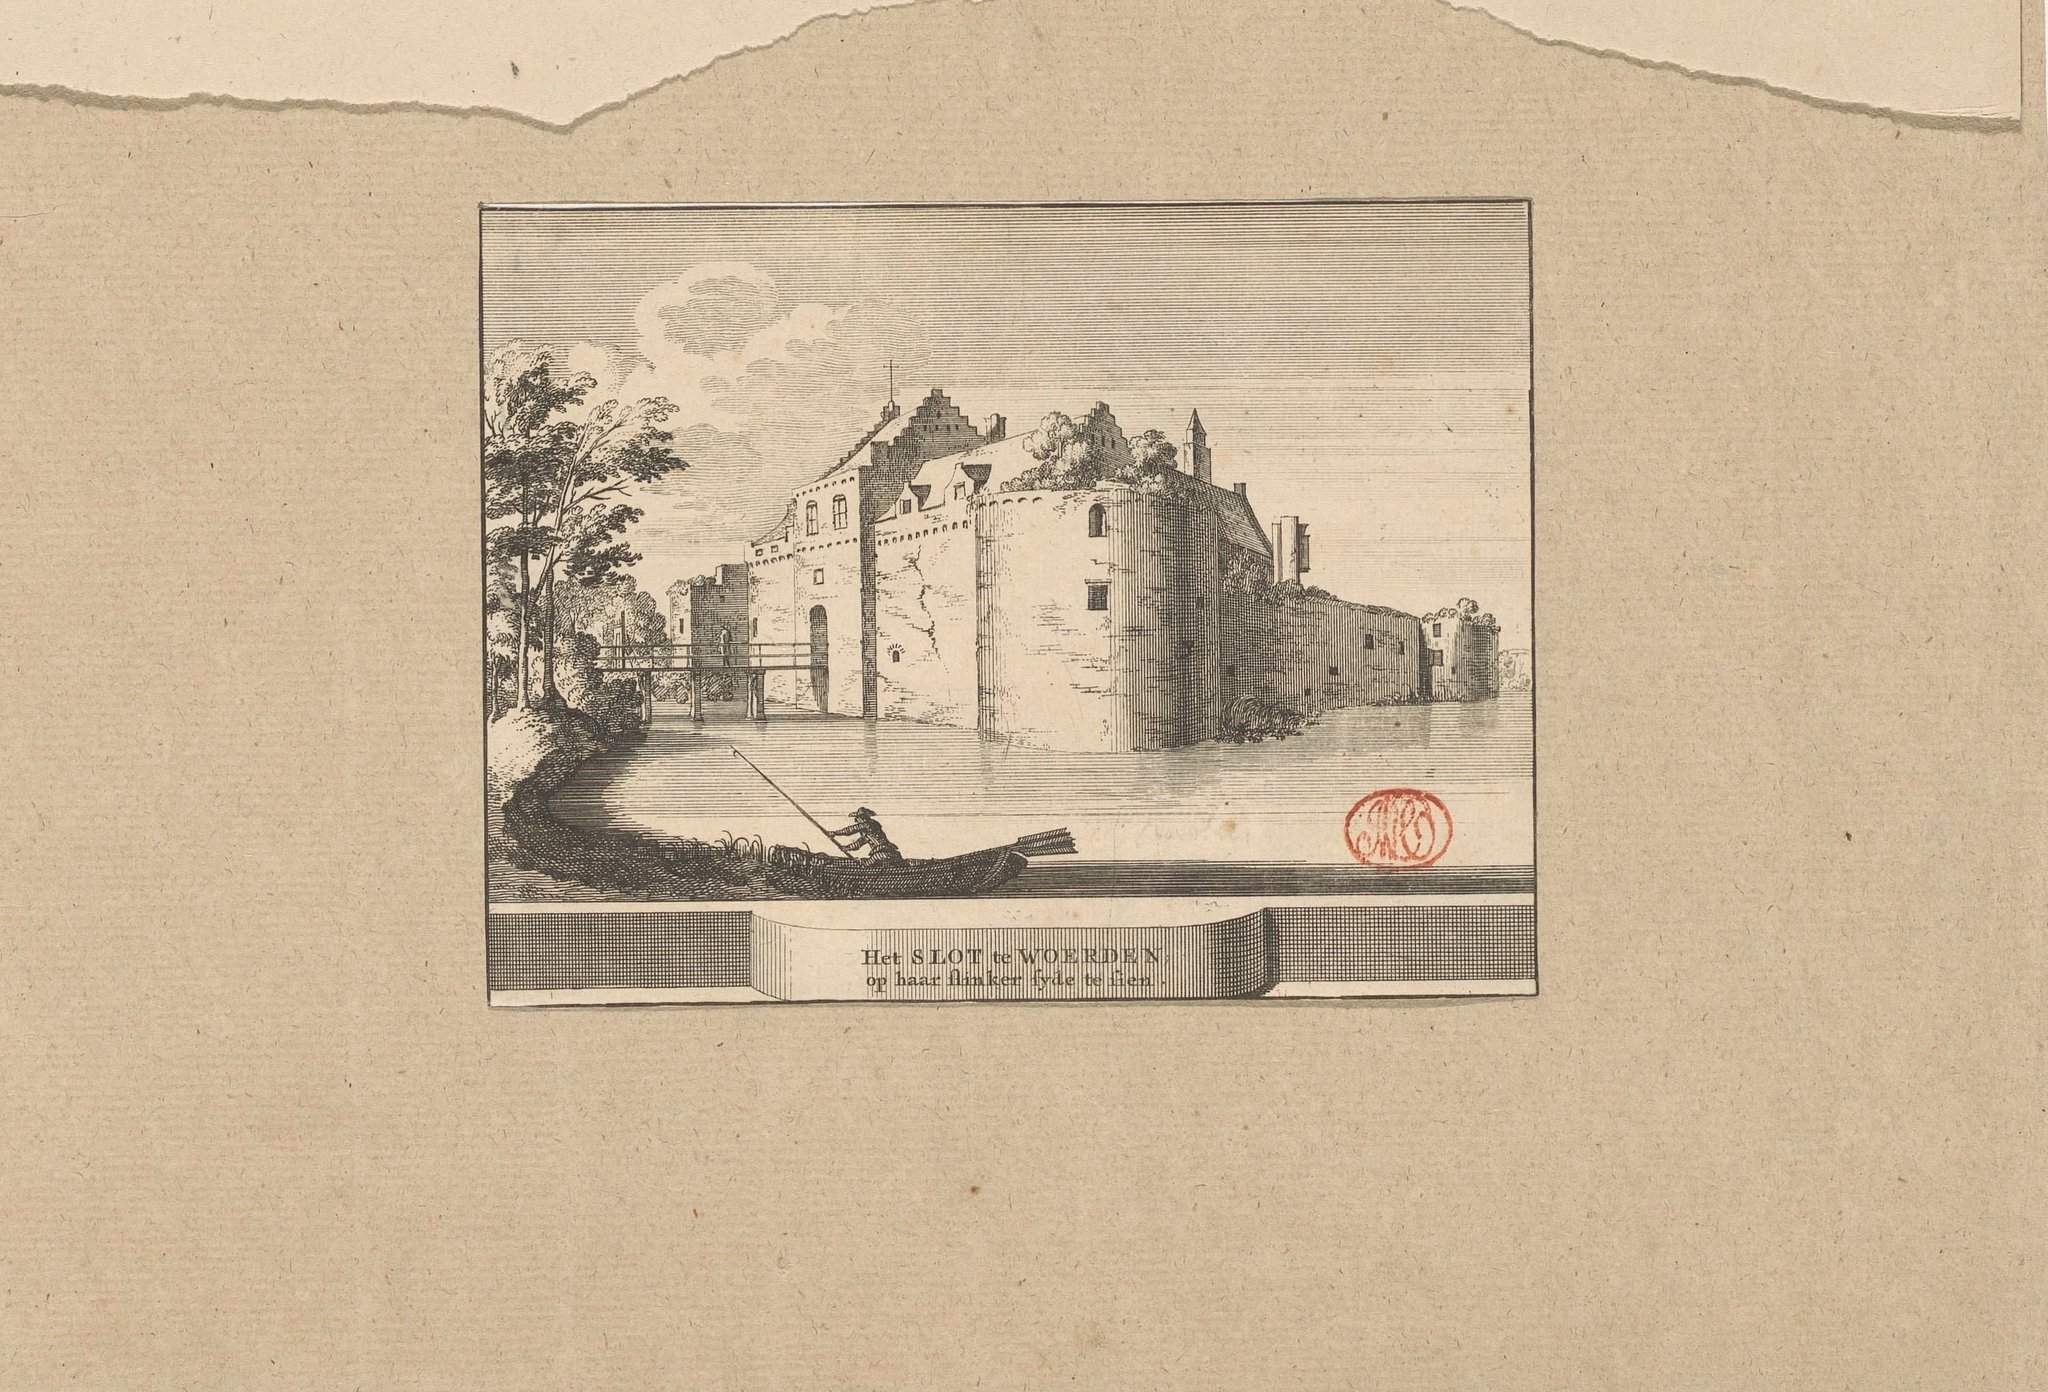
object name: print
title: 't Slot te Woerden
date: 1652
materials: paper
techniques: engraving, etching, letterpress printing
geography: amsterdam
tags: castle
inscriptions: collector's mark: Lugt 2228, collector's mark: Lugt 195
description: Prent gebruikt in: Blaeu, Johannes Willemszoon. Toonneel der steden van de Vereenighde Nederlanden. 2 delen. Amsterdam: Johannes Willemszoon Blaeu, 1652, dl. 1.